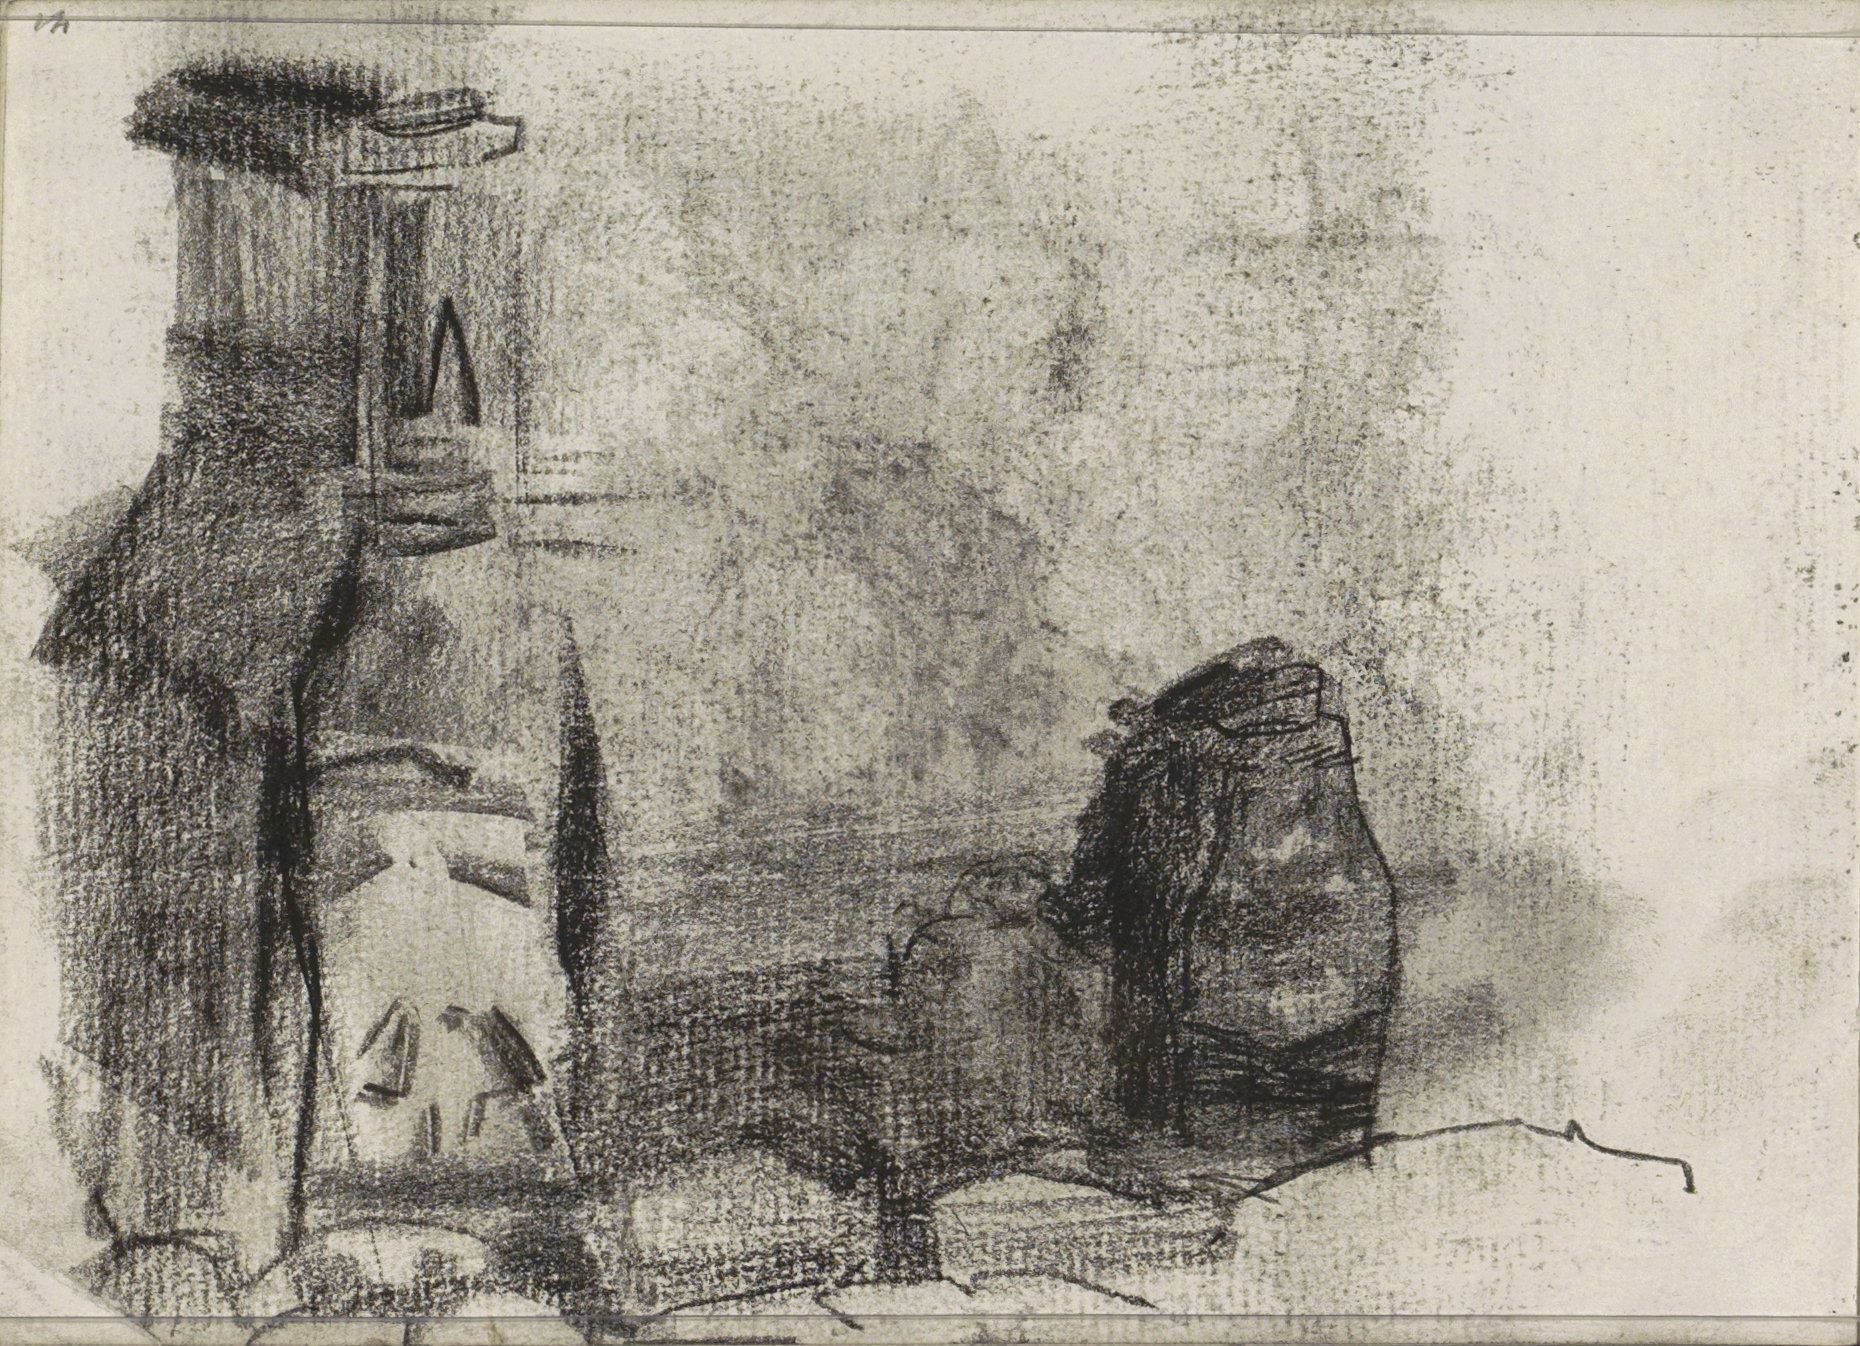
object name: sketchbook leaf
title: Voorwerpen, mogelijk onder andere een kachel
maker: isaac israels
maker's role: draughtsman, painter, print maker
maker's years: 1865-1934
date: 1875-1934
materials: chalk, paper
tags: heating stove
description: Blad 12 verso uit schetsboek LVI met 26 bladen.